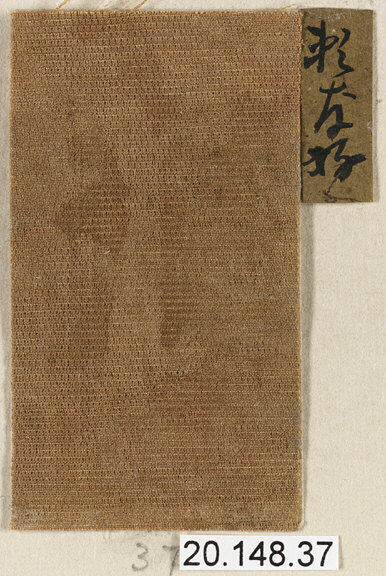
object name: piece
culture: japanese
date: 1101-1200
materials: silk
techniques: compound weave